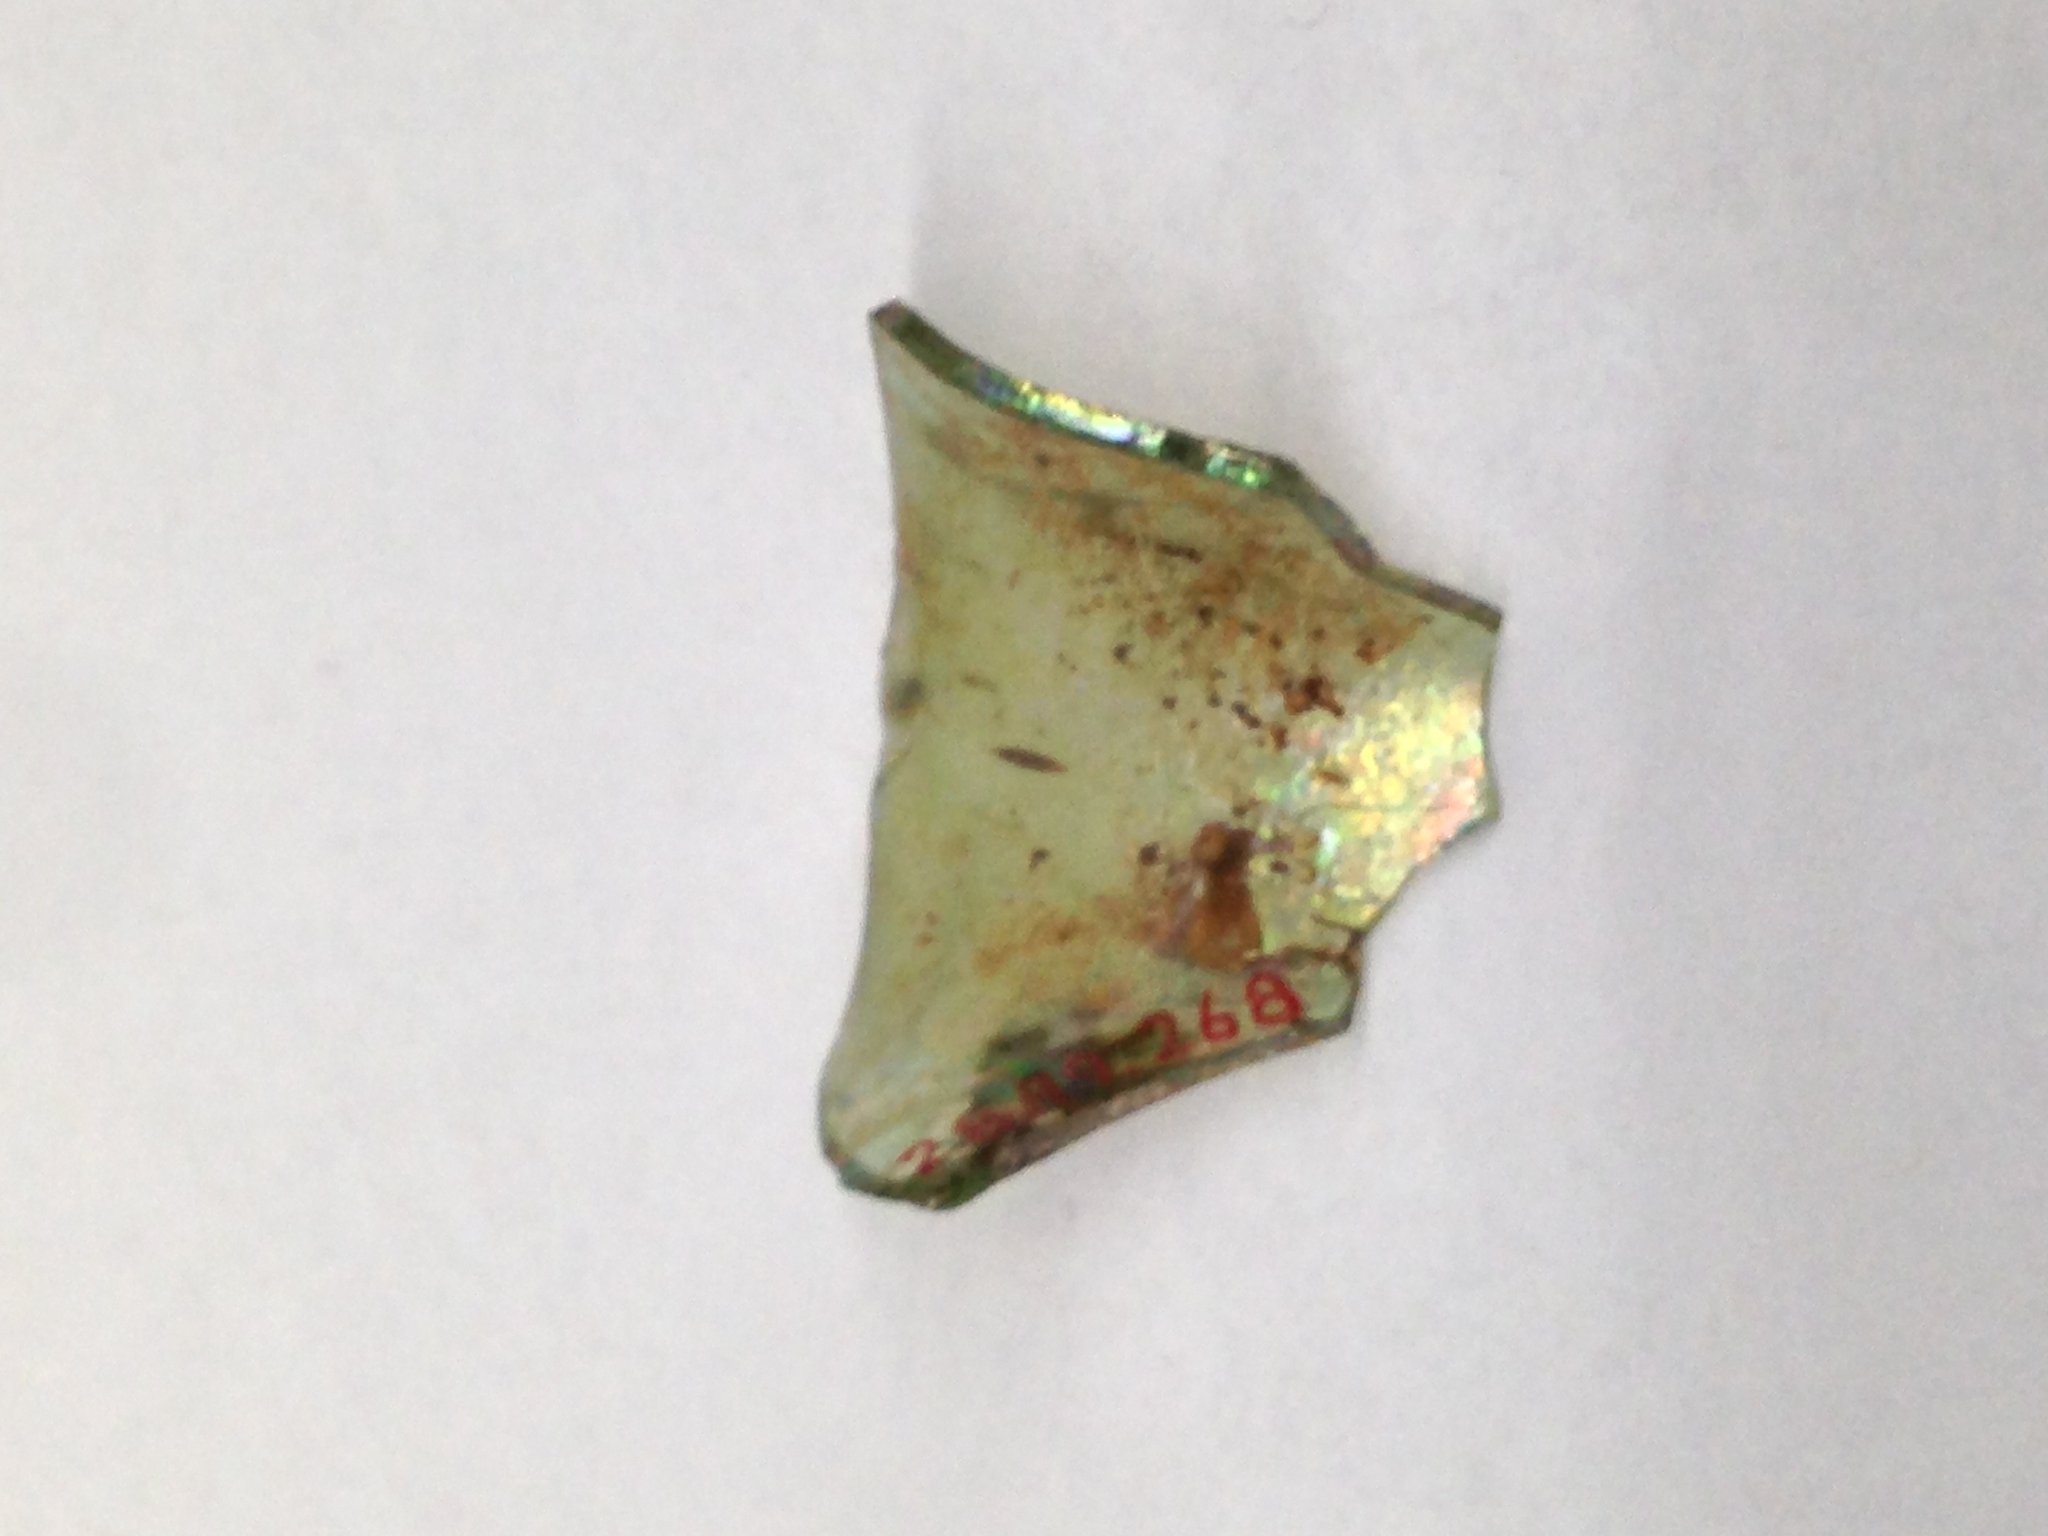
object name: fragment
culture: european or middle eastern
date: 1150-1250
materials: ceramic, glass